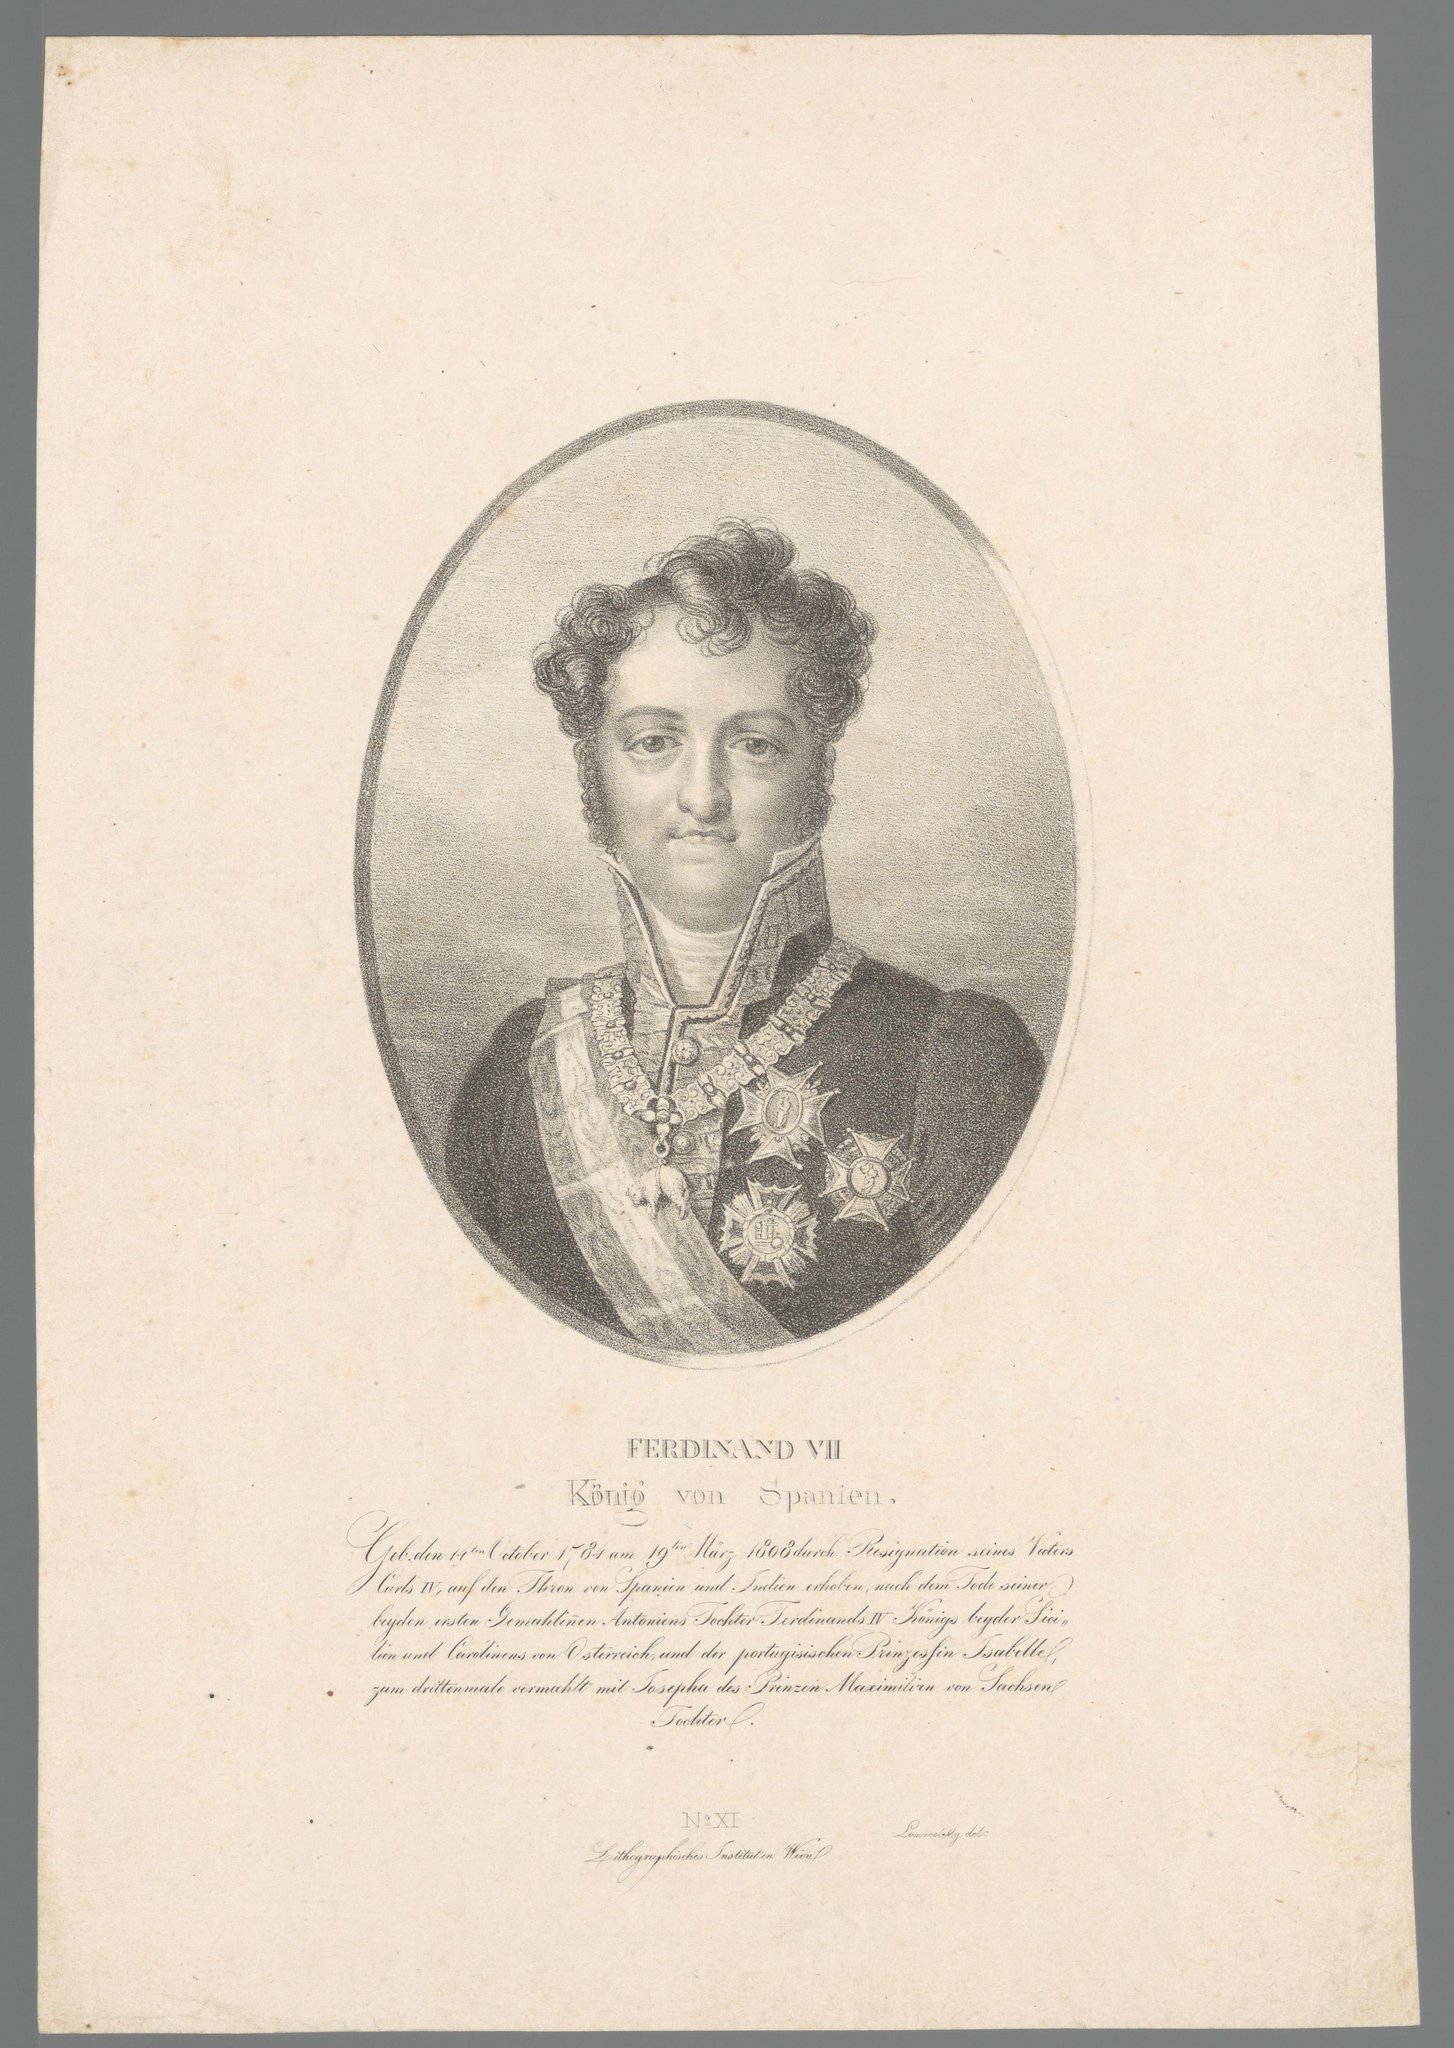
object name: print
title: Ferdinand VII König von Spanien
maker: josef lanzedelly (il vecchio)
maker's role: print maker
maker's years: 1774-1832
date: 1784-1832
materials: paper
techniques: lithograph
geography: vienna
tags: ferdinand vii (koning van spanje), historical persons, king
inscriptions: collector's mark: Lugt 2228